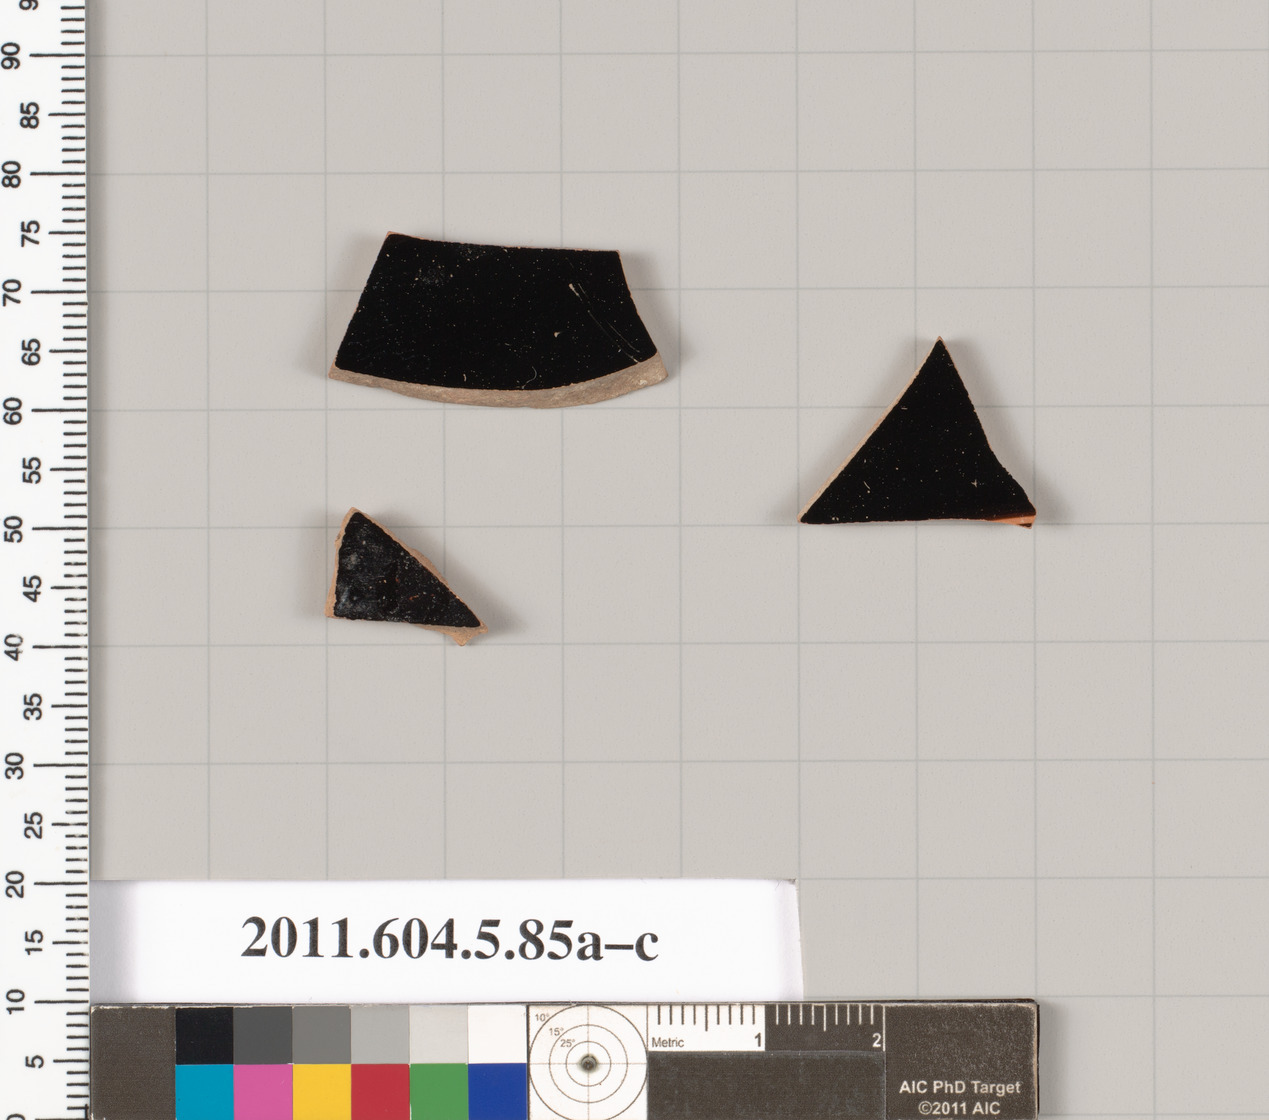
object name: kylix fragment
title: Terracotta fragments of kylikes (drinking cups)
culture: greek, attic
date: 534-468 BCE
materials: terracotta